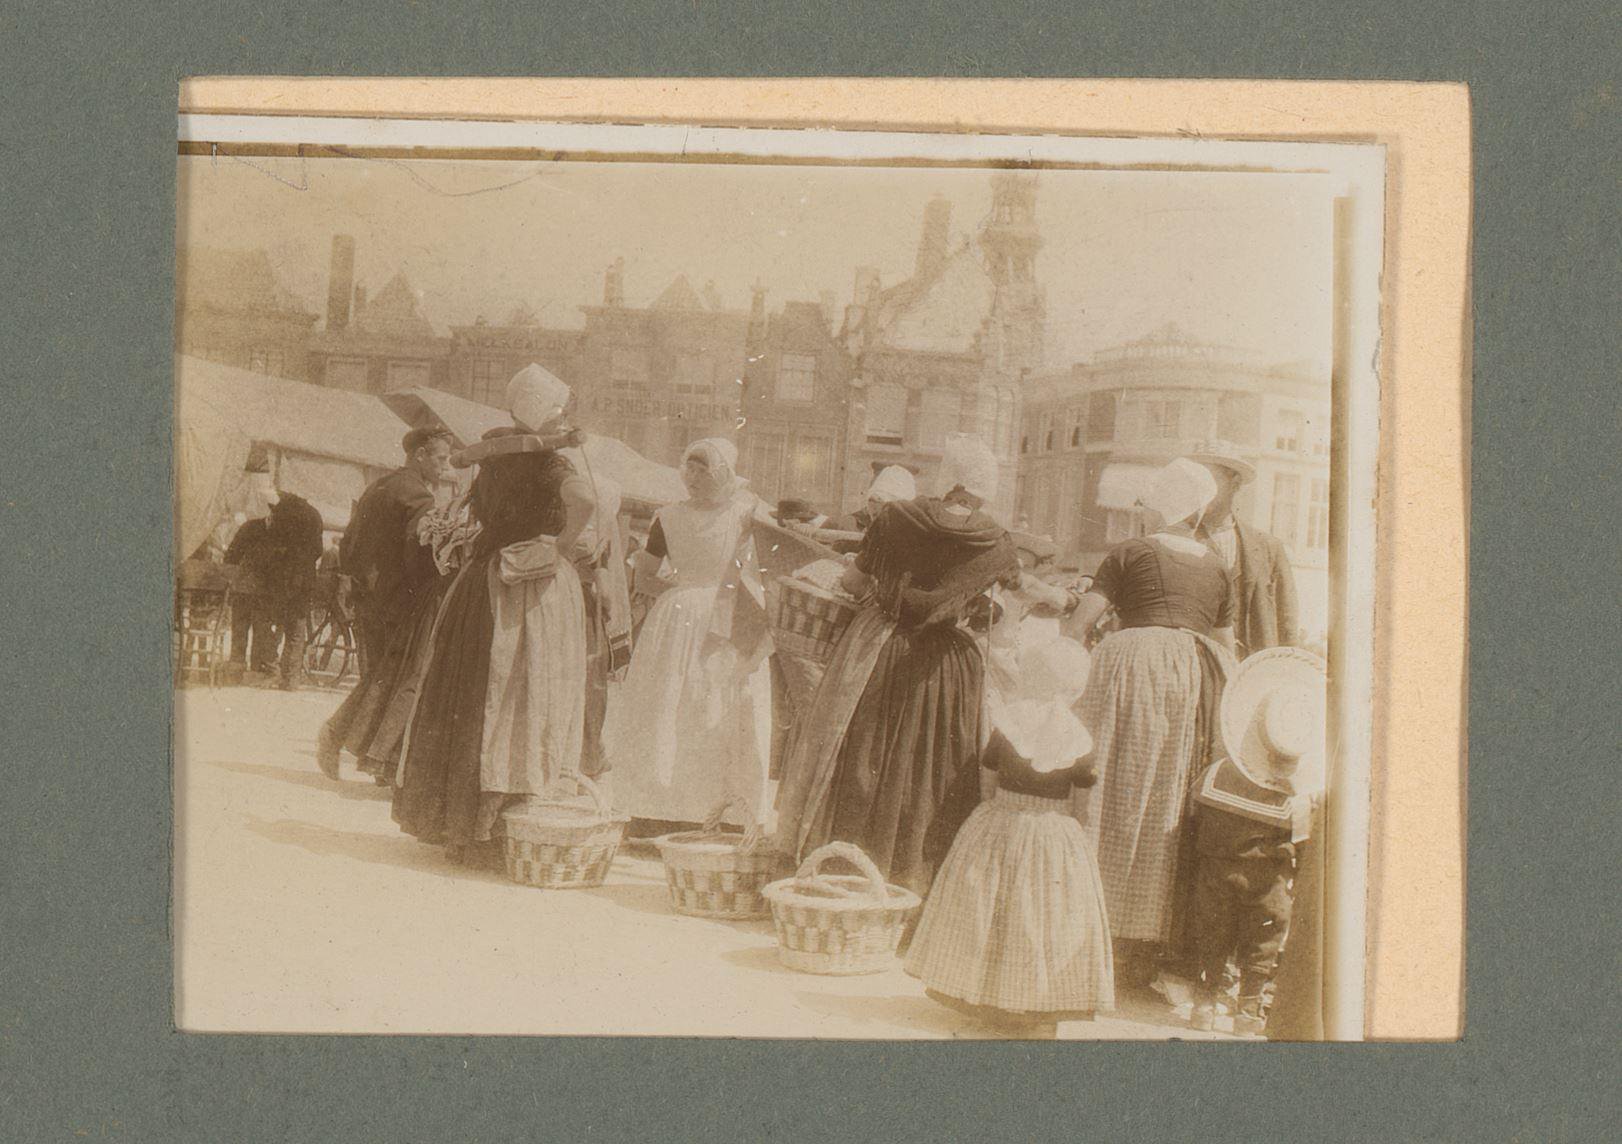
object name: photograph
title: Vrouwen in klederdracht op een markt, met manden en een juk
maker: george hidderley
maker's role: fotograaf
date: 1920-1940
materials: photographic support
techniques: gelatin silver print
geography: netherlands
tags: historical persons, folk costume, regional costume, market